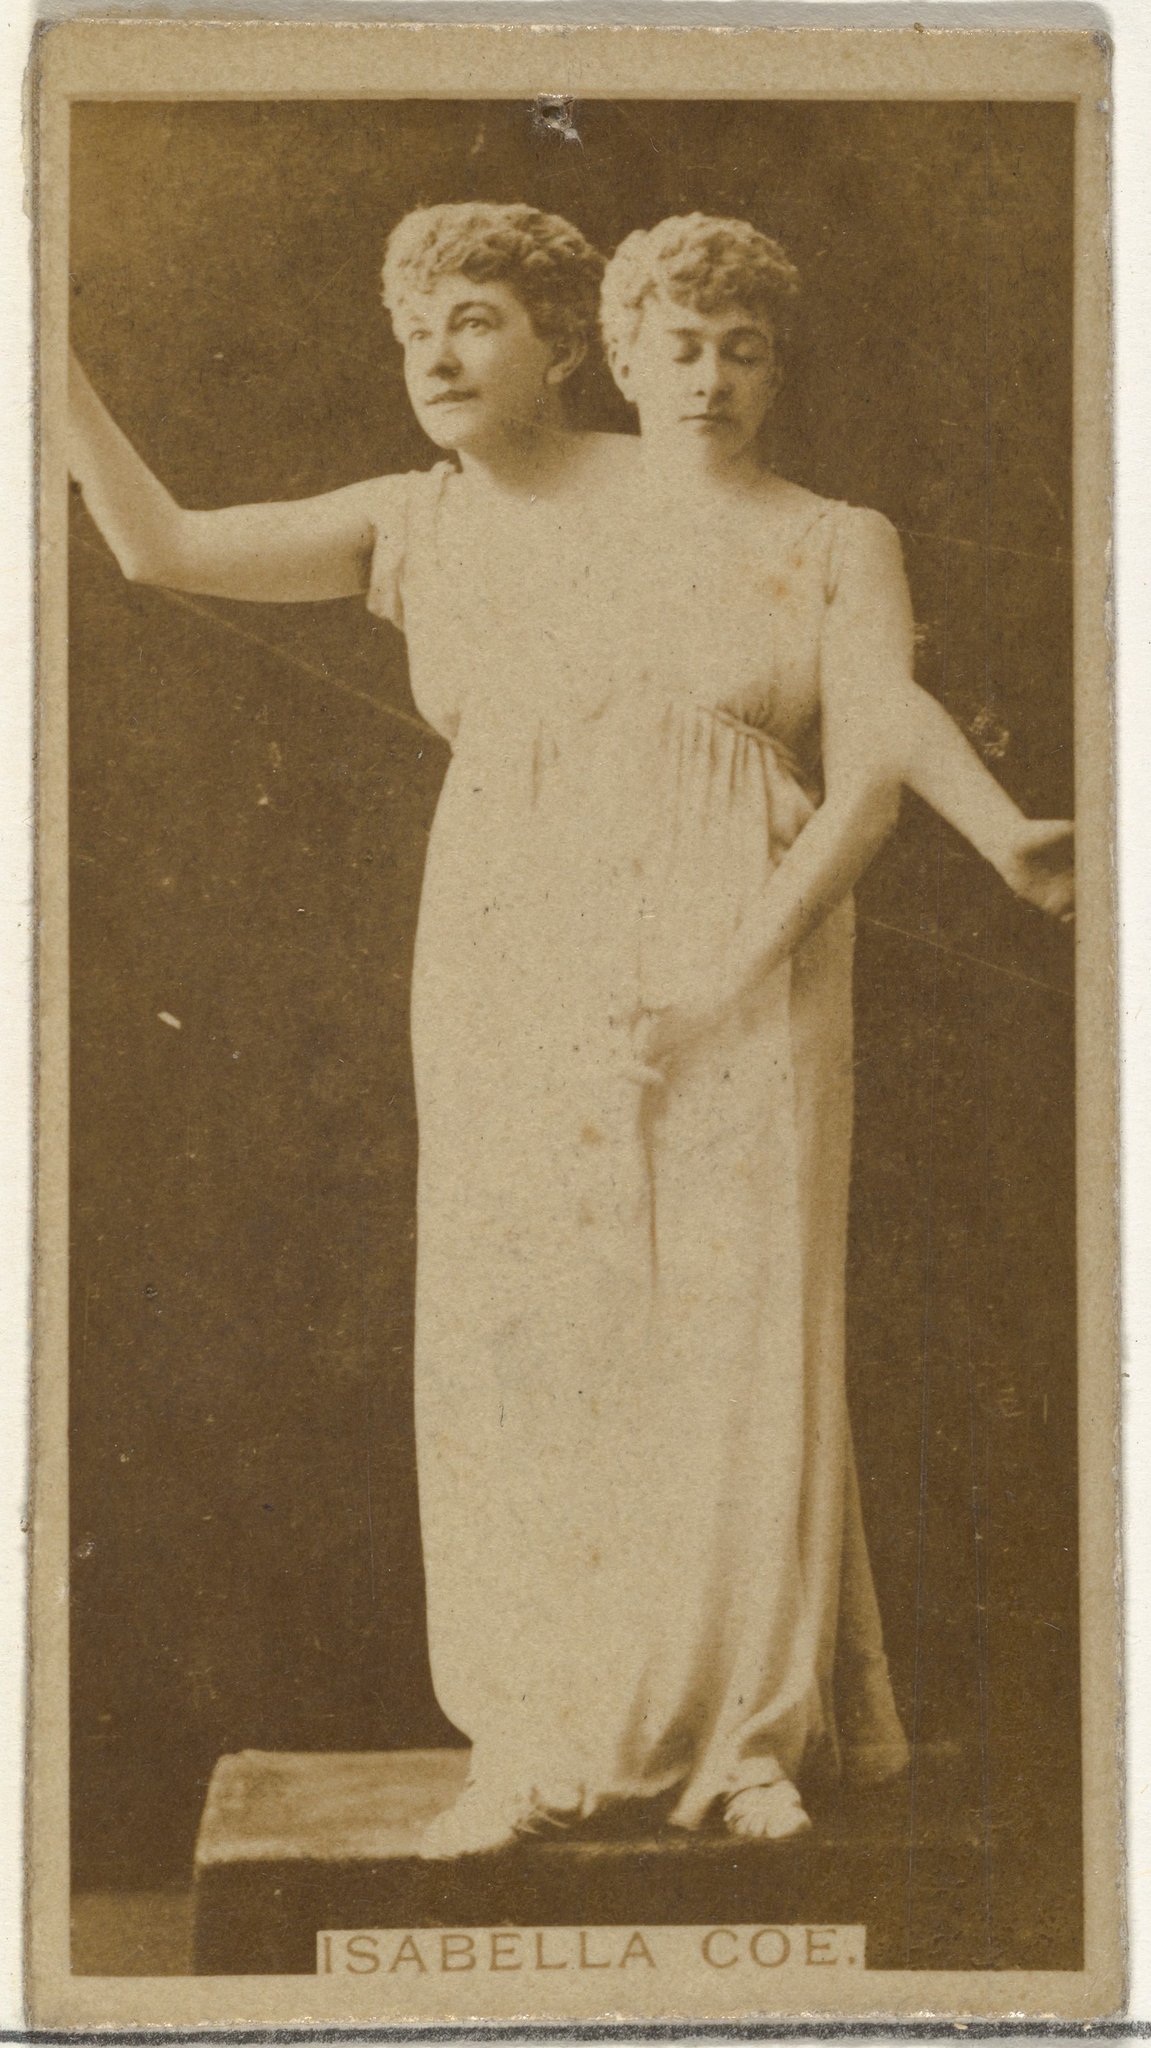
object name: photograph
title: Isabella Coe, from the Actors and Actresses series (N145-8) issued by Duke Sons & Co. to promote Duke Cigarettes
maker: w. duke, sons & co.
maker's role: publisher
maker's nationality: american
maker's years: 1870-1920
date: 1891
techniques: albumen silver print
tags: portraits,women,actresses